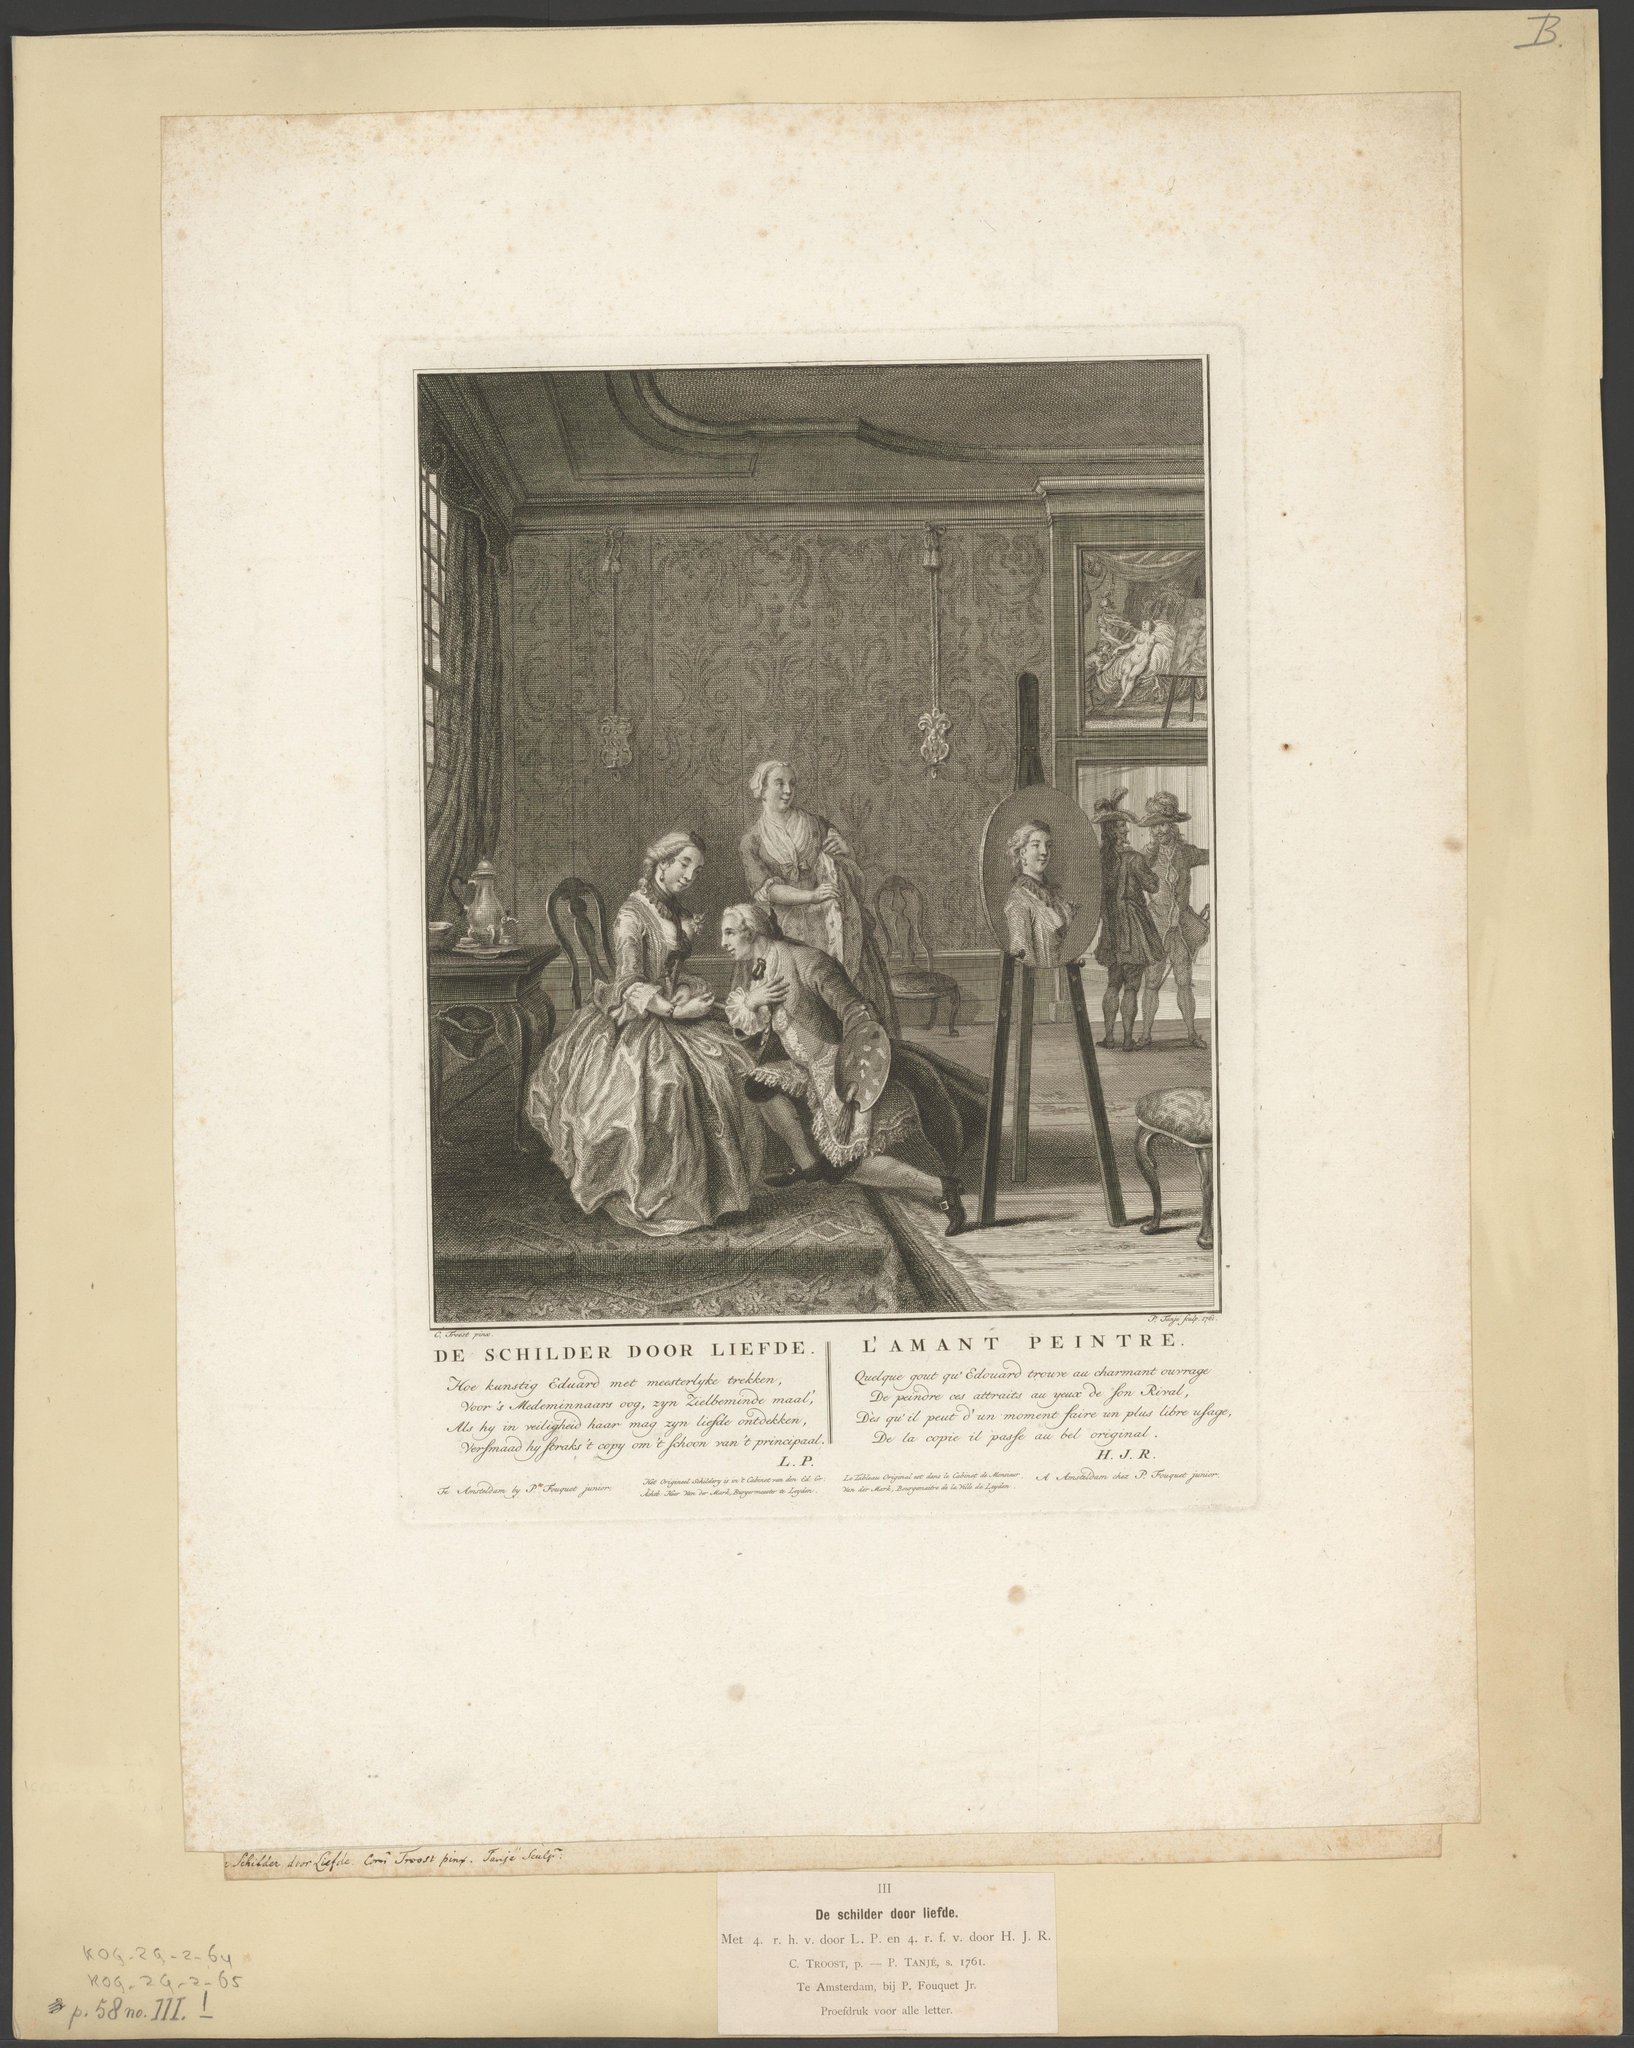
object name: print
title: De schilder door liefde / L'amant peintre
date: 1761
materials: paper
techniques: engraving, etching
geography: amsterdam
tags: kneeling figure, apelles paints campaspe and falls in love with her; alexander yields her to him, painter working from clothed model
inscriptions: collector's mark: Lugt 2488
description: De schilder Eduard verklaart Leonoor, wier portret hij vervaardigd heeft, zijn liefde. Bij de deur staat Leonoors jaloerse man Don Pedro, die door de schildersknecht bezig wordt gehouden. Boven de deur hangt een schilderij met een voorstelling van Alexander, die de schilder Apelles zijn minnares Campaspe ten geschenke geeft. Onderaan in de marge vierregelige verzen in het Nederlands en het Frans. Scène uit het tweede bedrijf van het toneelstuk De schilder door liefde, van Molière.